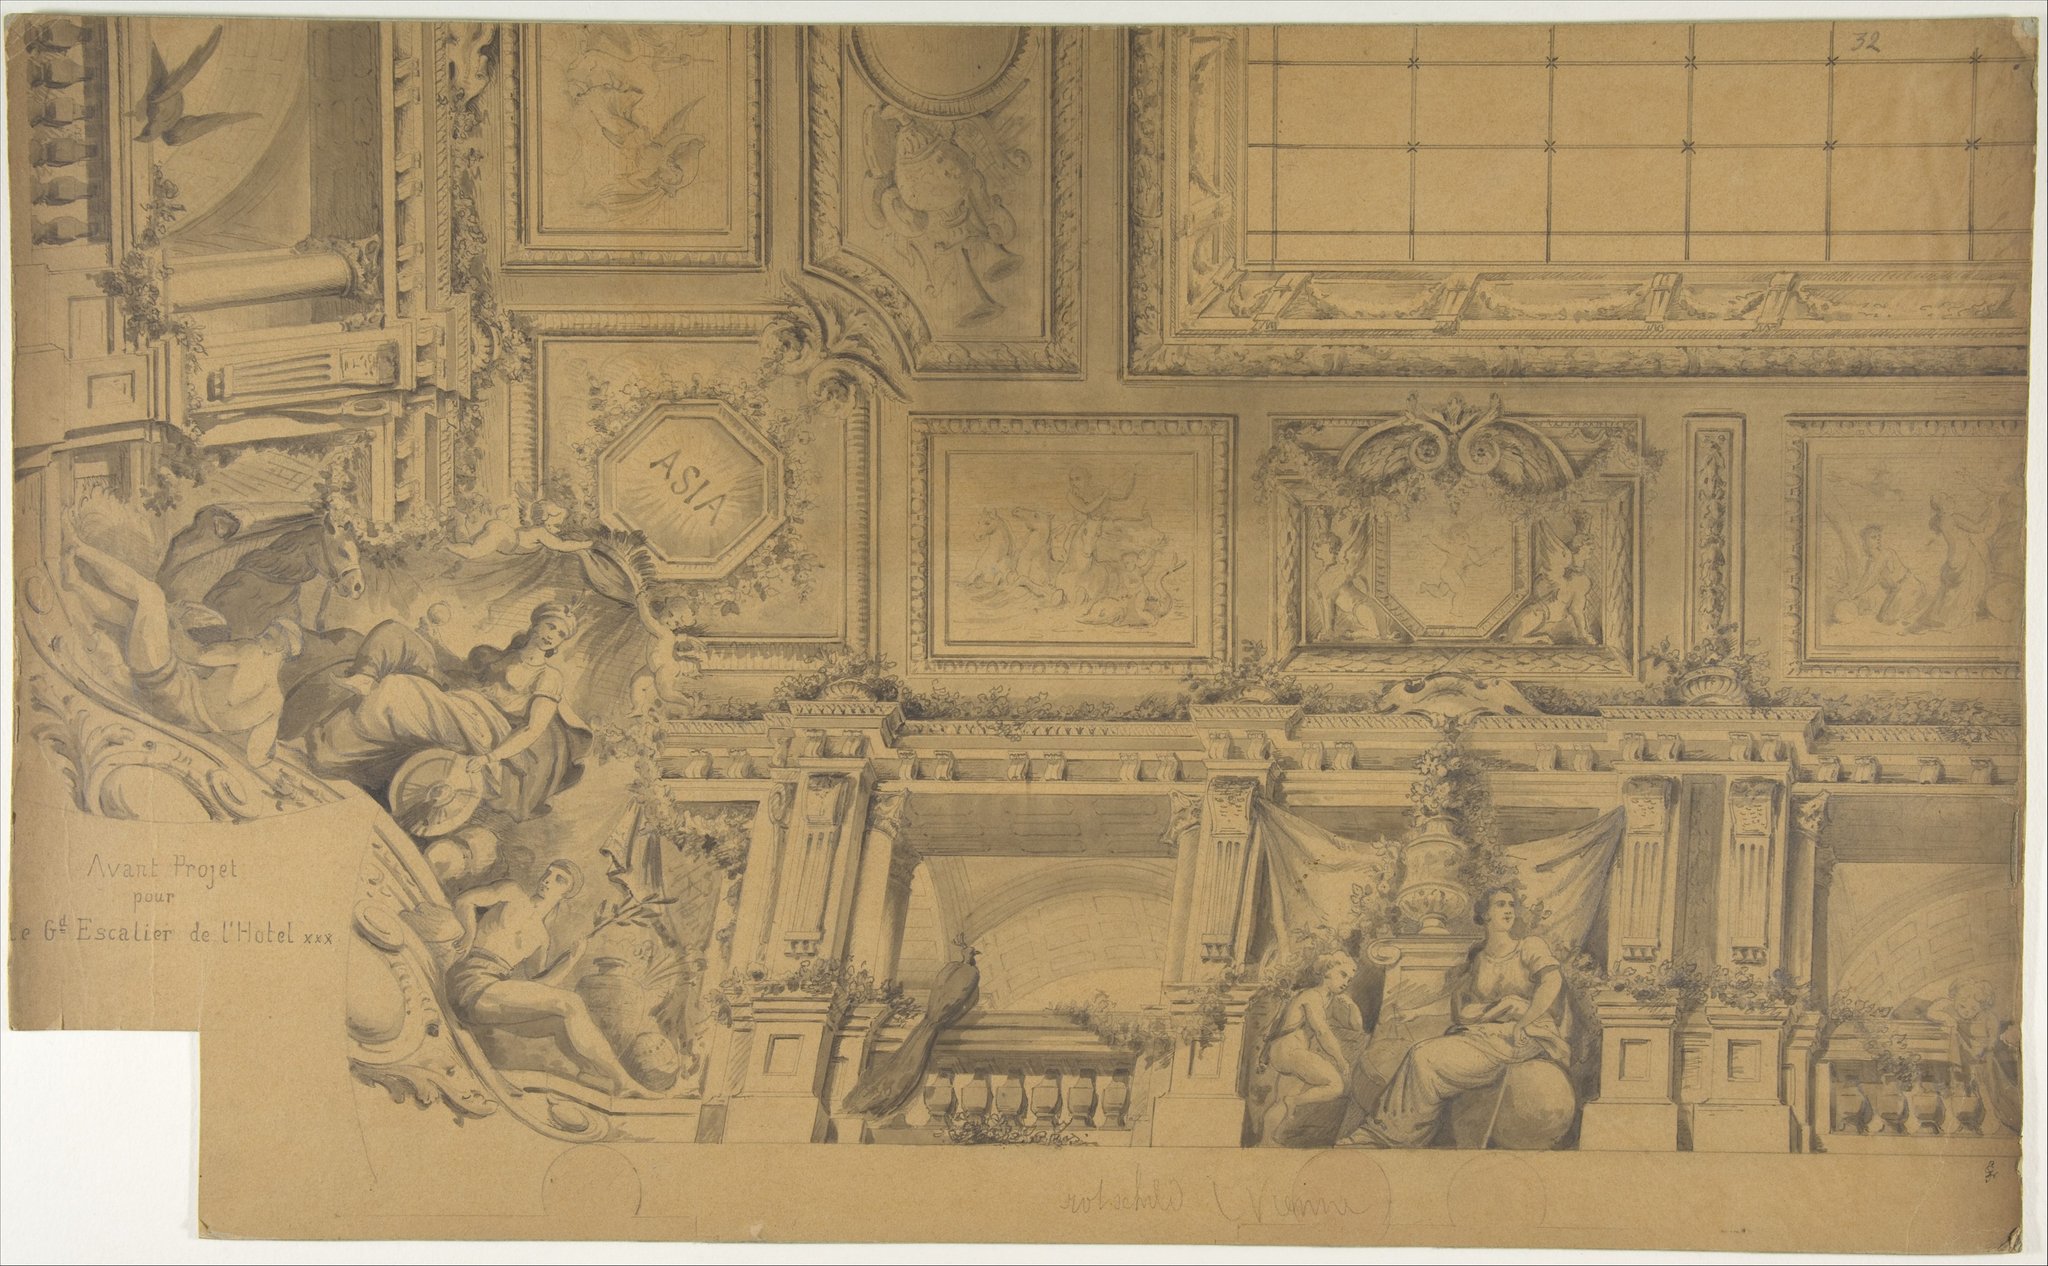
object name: drawing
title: Ceiling and Cove Designs for Stairway, Hôtel Rothschild, Vienna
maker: jules-edmond-charles lachaise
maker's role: artist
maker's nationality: french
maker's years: 1897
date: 1850-1910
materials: cardboard, graphite, ink, paper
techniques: brush, pen, wash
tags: animals,birds,men,women